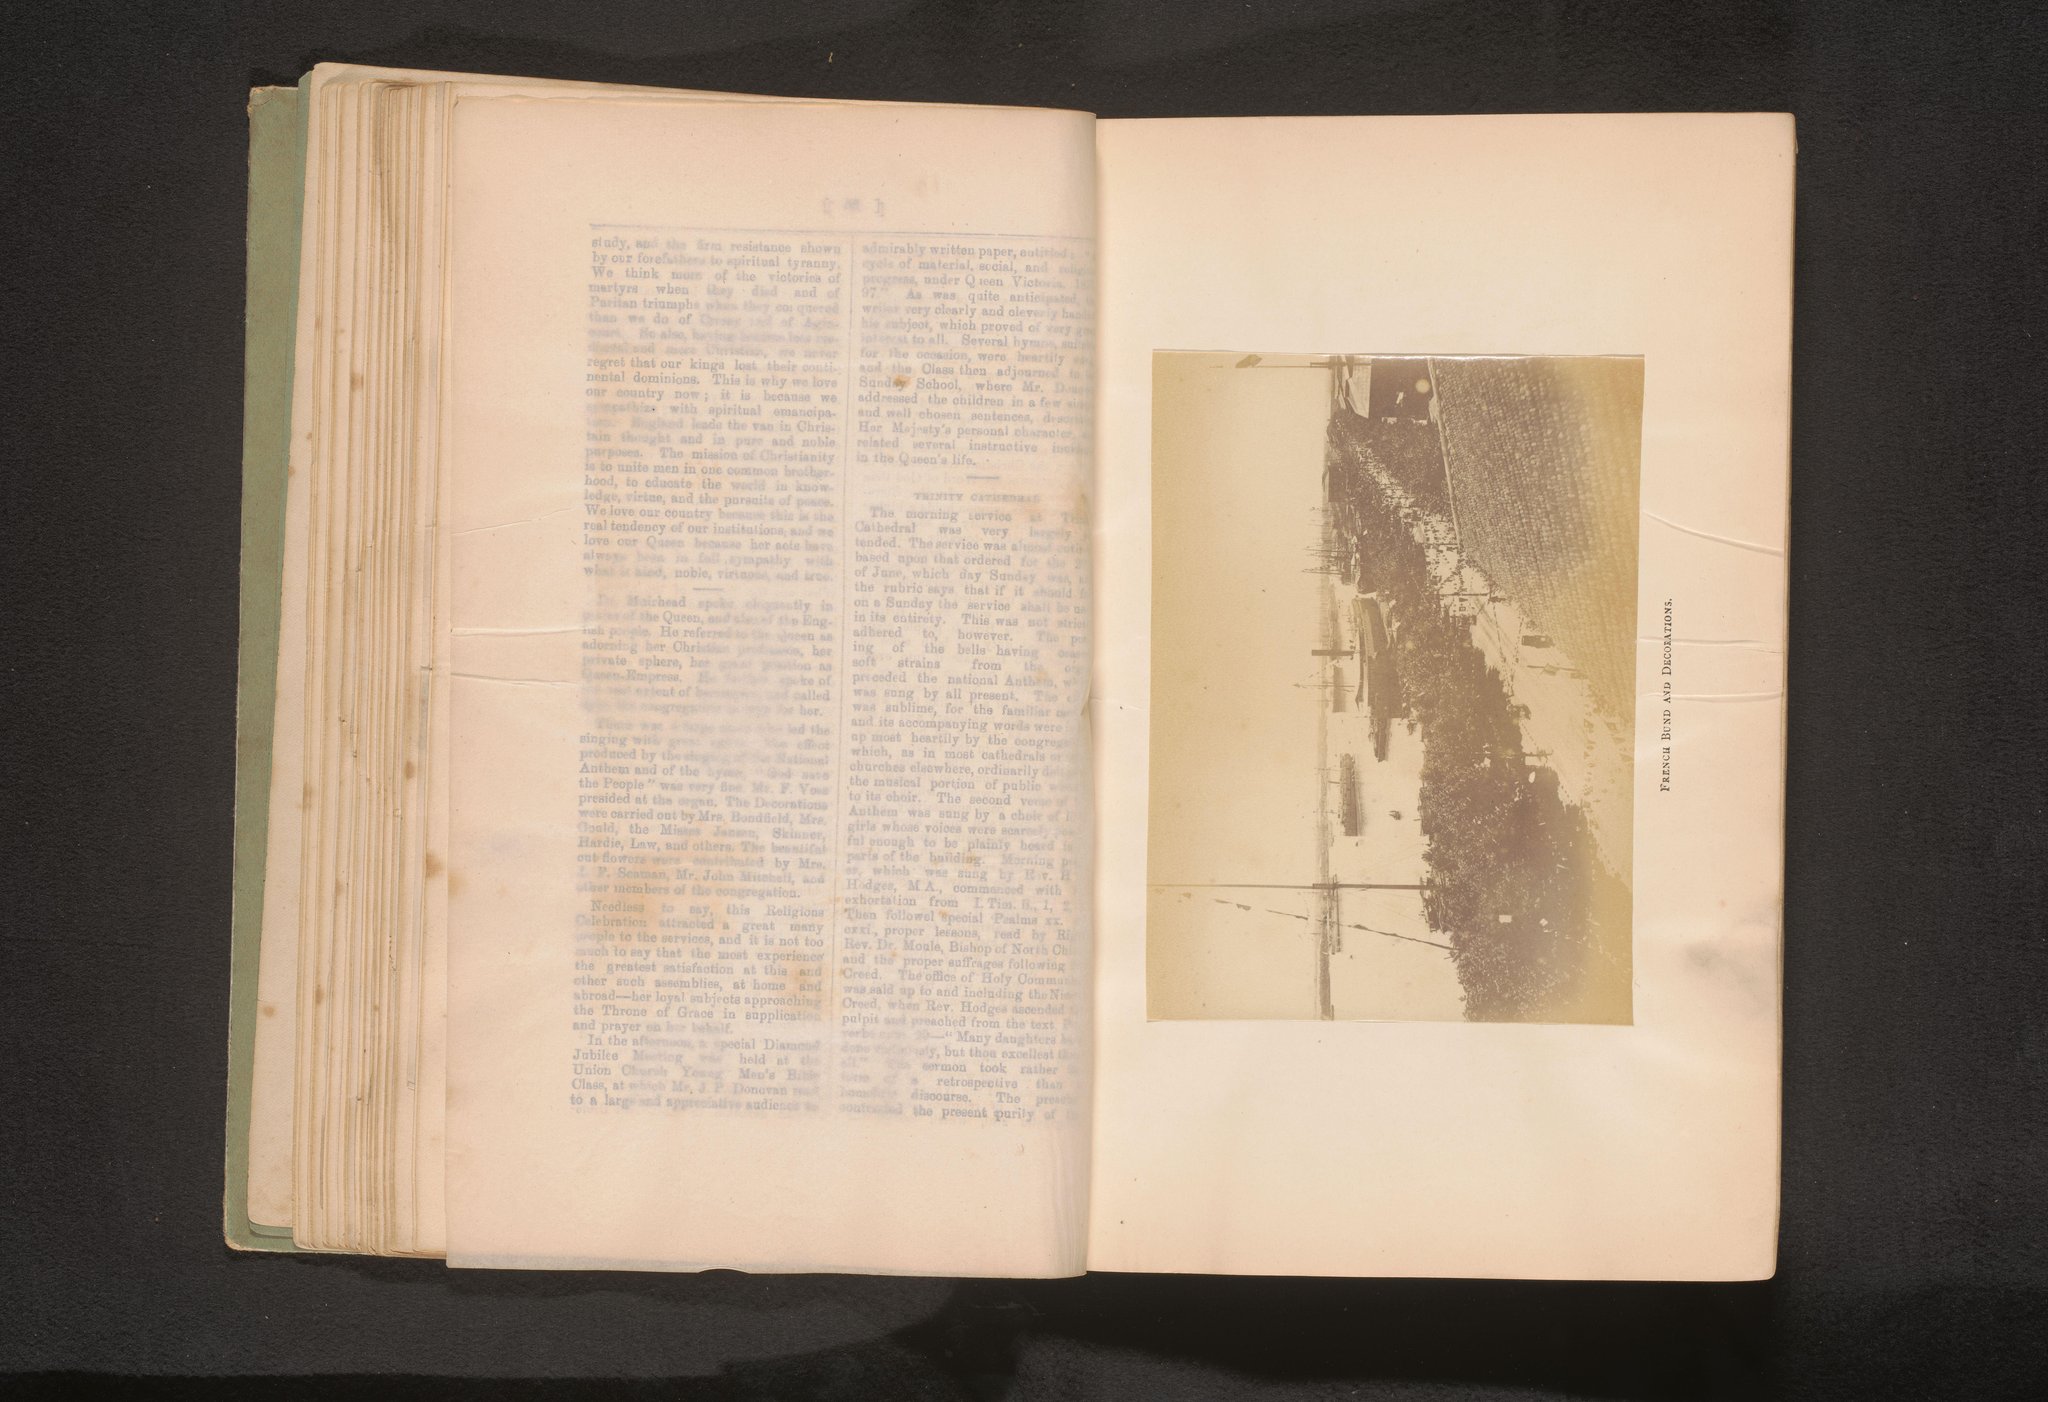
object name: page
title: French Bund and decorations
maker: w.r. kahler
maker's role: fotograaf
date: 1897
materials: photographic support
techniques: albumen print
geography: shanghai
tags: festivities (+ wreath, garland ~ festive activities), avenue, boulevard, promenade, esplanade, commemoration, jubilee